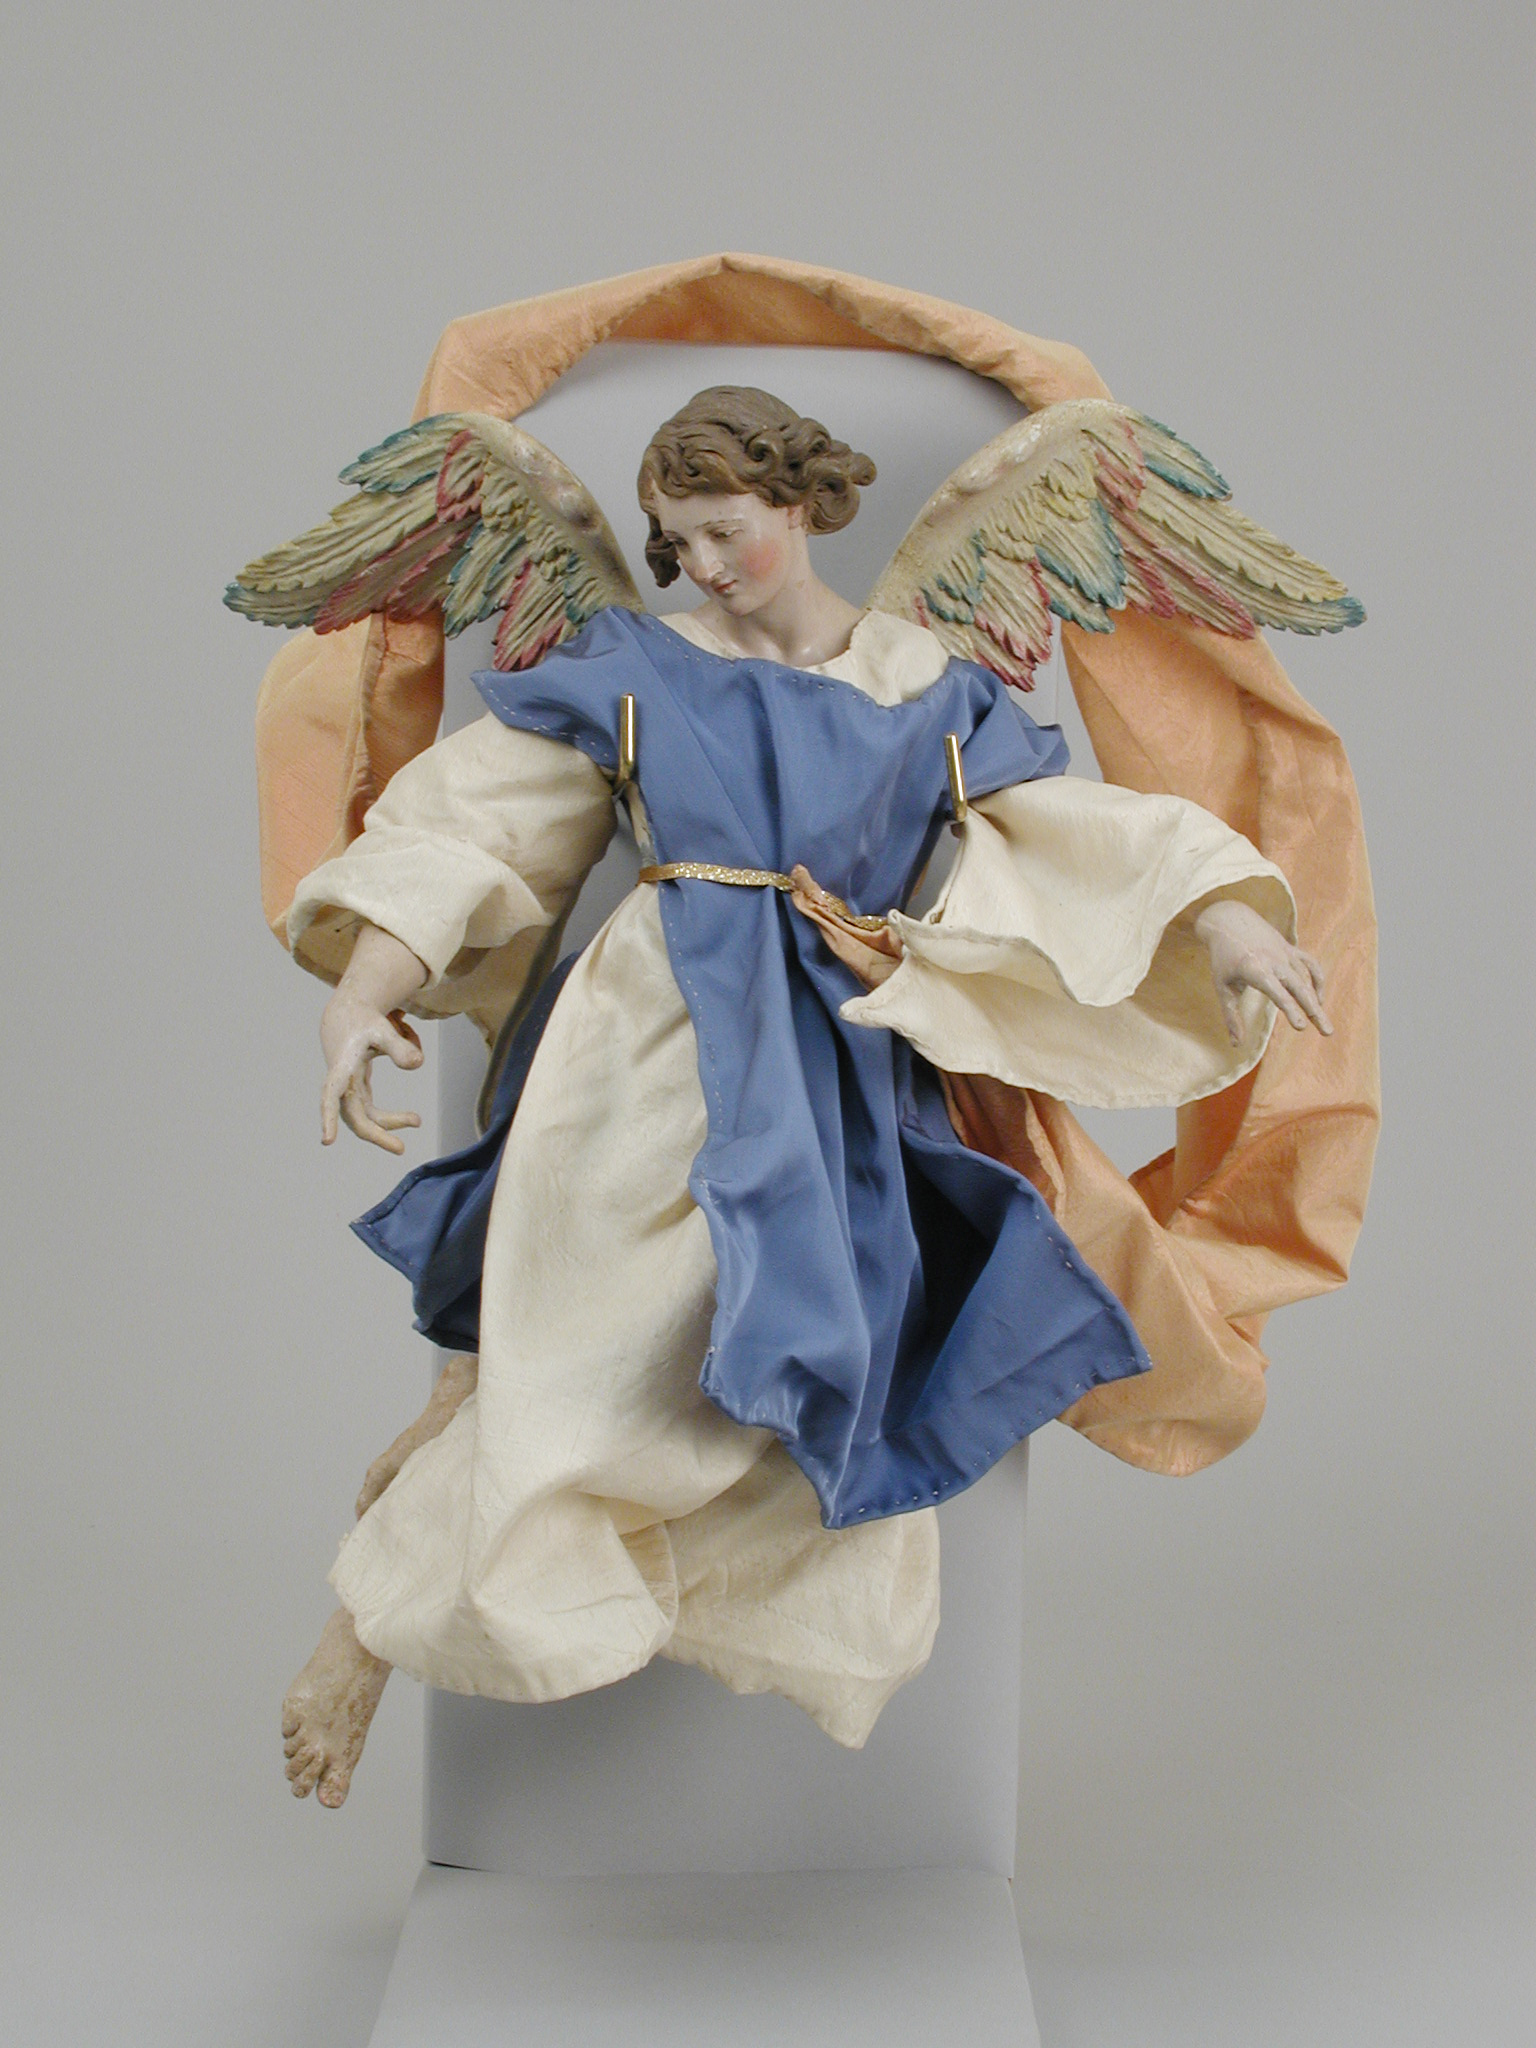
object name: crèche figure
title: Angel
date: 1767-1833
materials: silk, terracotta, fiber, metal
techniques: polychrome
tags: angels